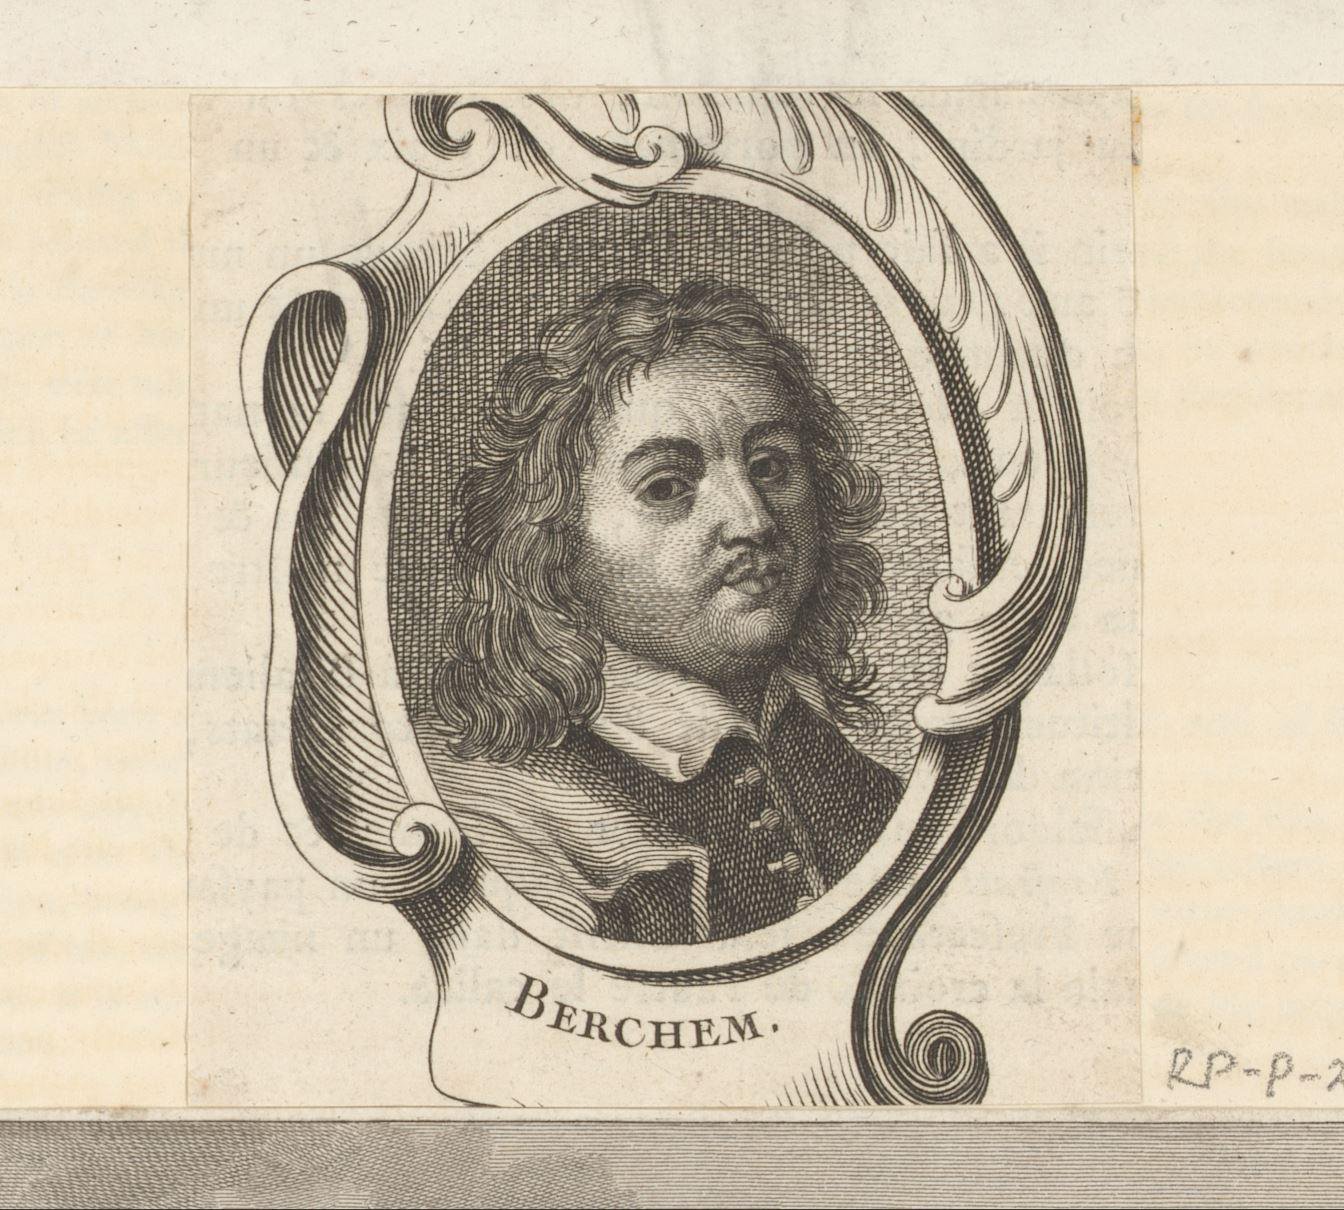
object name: print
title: Berchem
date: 1745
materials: paper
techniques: engraving, letterpress printing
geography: paris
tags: amsterdam, nicolaes pietersz berchem, historical persons, portrait, self-portrait of painter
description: Prent uit: Dézallier d'Argenville, Antoine Joseph. Abrégé de la vie des plus fameux peintres. 4 dln. Parijs: De Bure l'aîné, 1745, dl. 2, p. 92. De samensteller heeft deze prent in het album geplakt als illustratie bij: Pilkington, Matthew en Johann Heinrich Füssli. A dictionary of painters, from the revival of the art to the present period. 4 dln. Londen: John Crowder, 1805, dl. 1, p. 42.